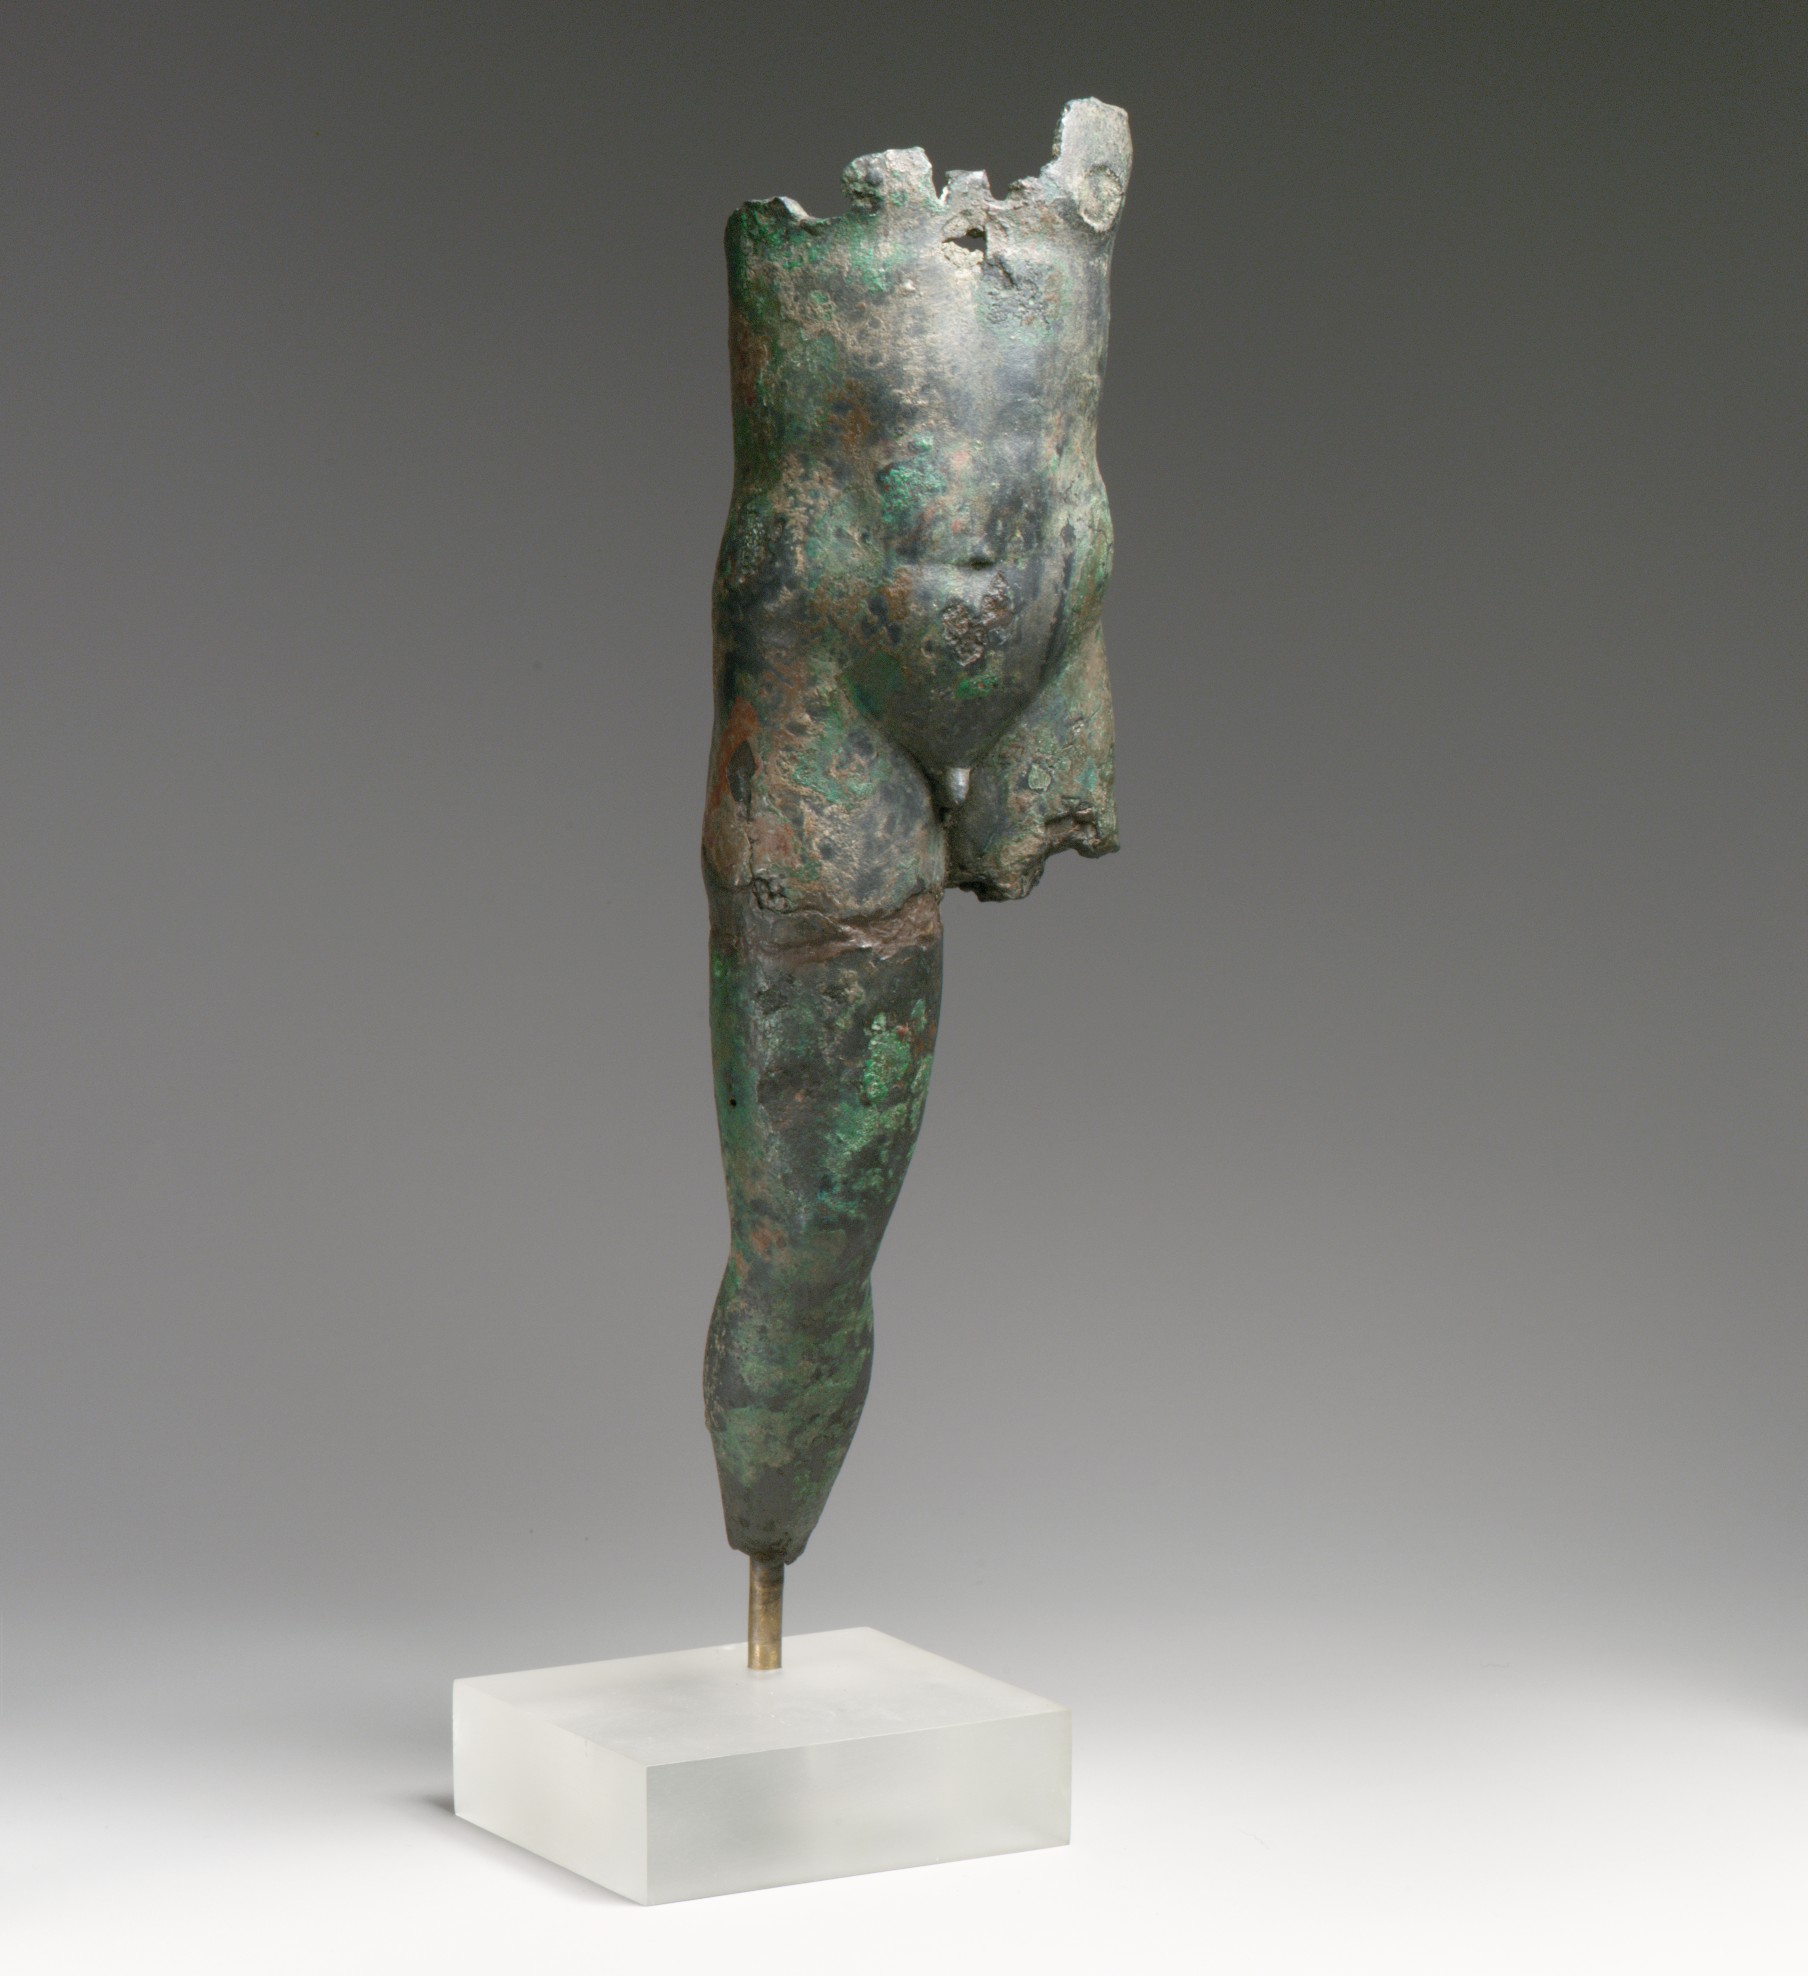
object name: statuette of a boy, fragment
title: Bronze statuette of a man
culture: greek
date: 451-475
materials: bronze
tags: men